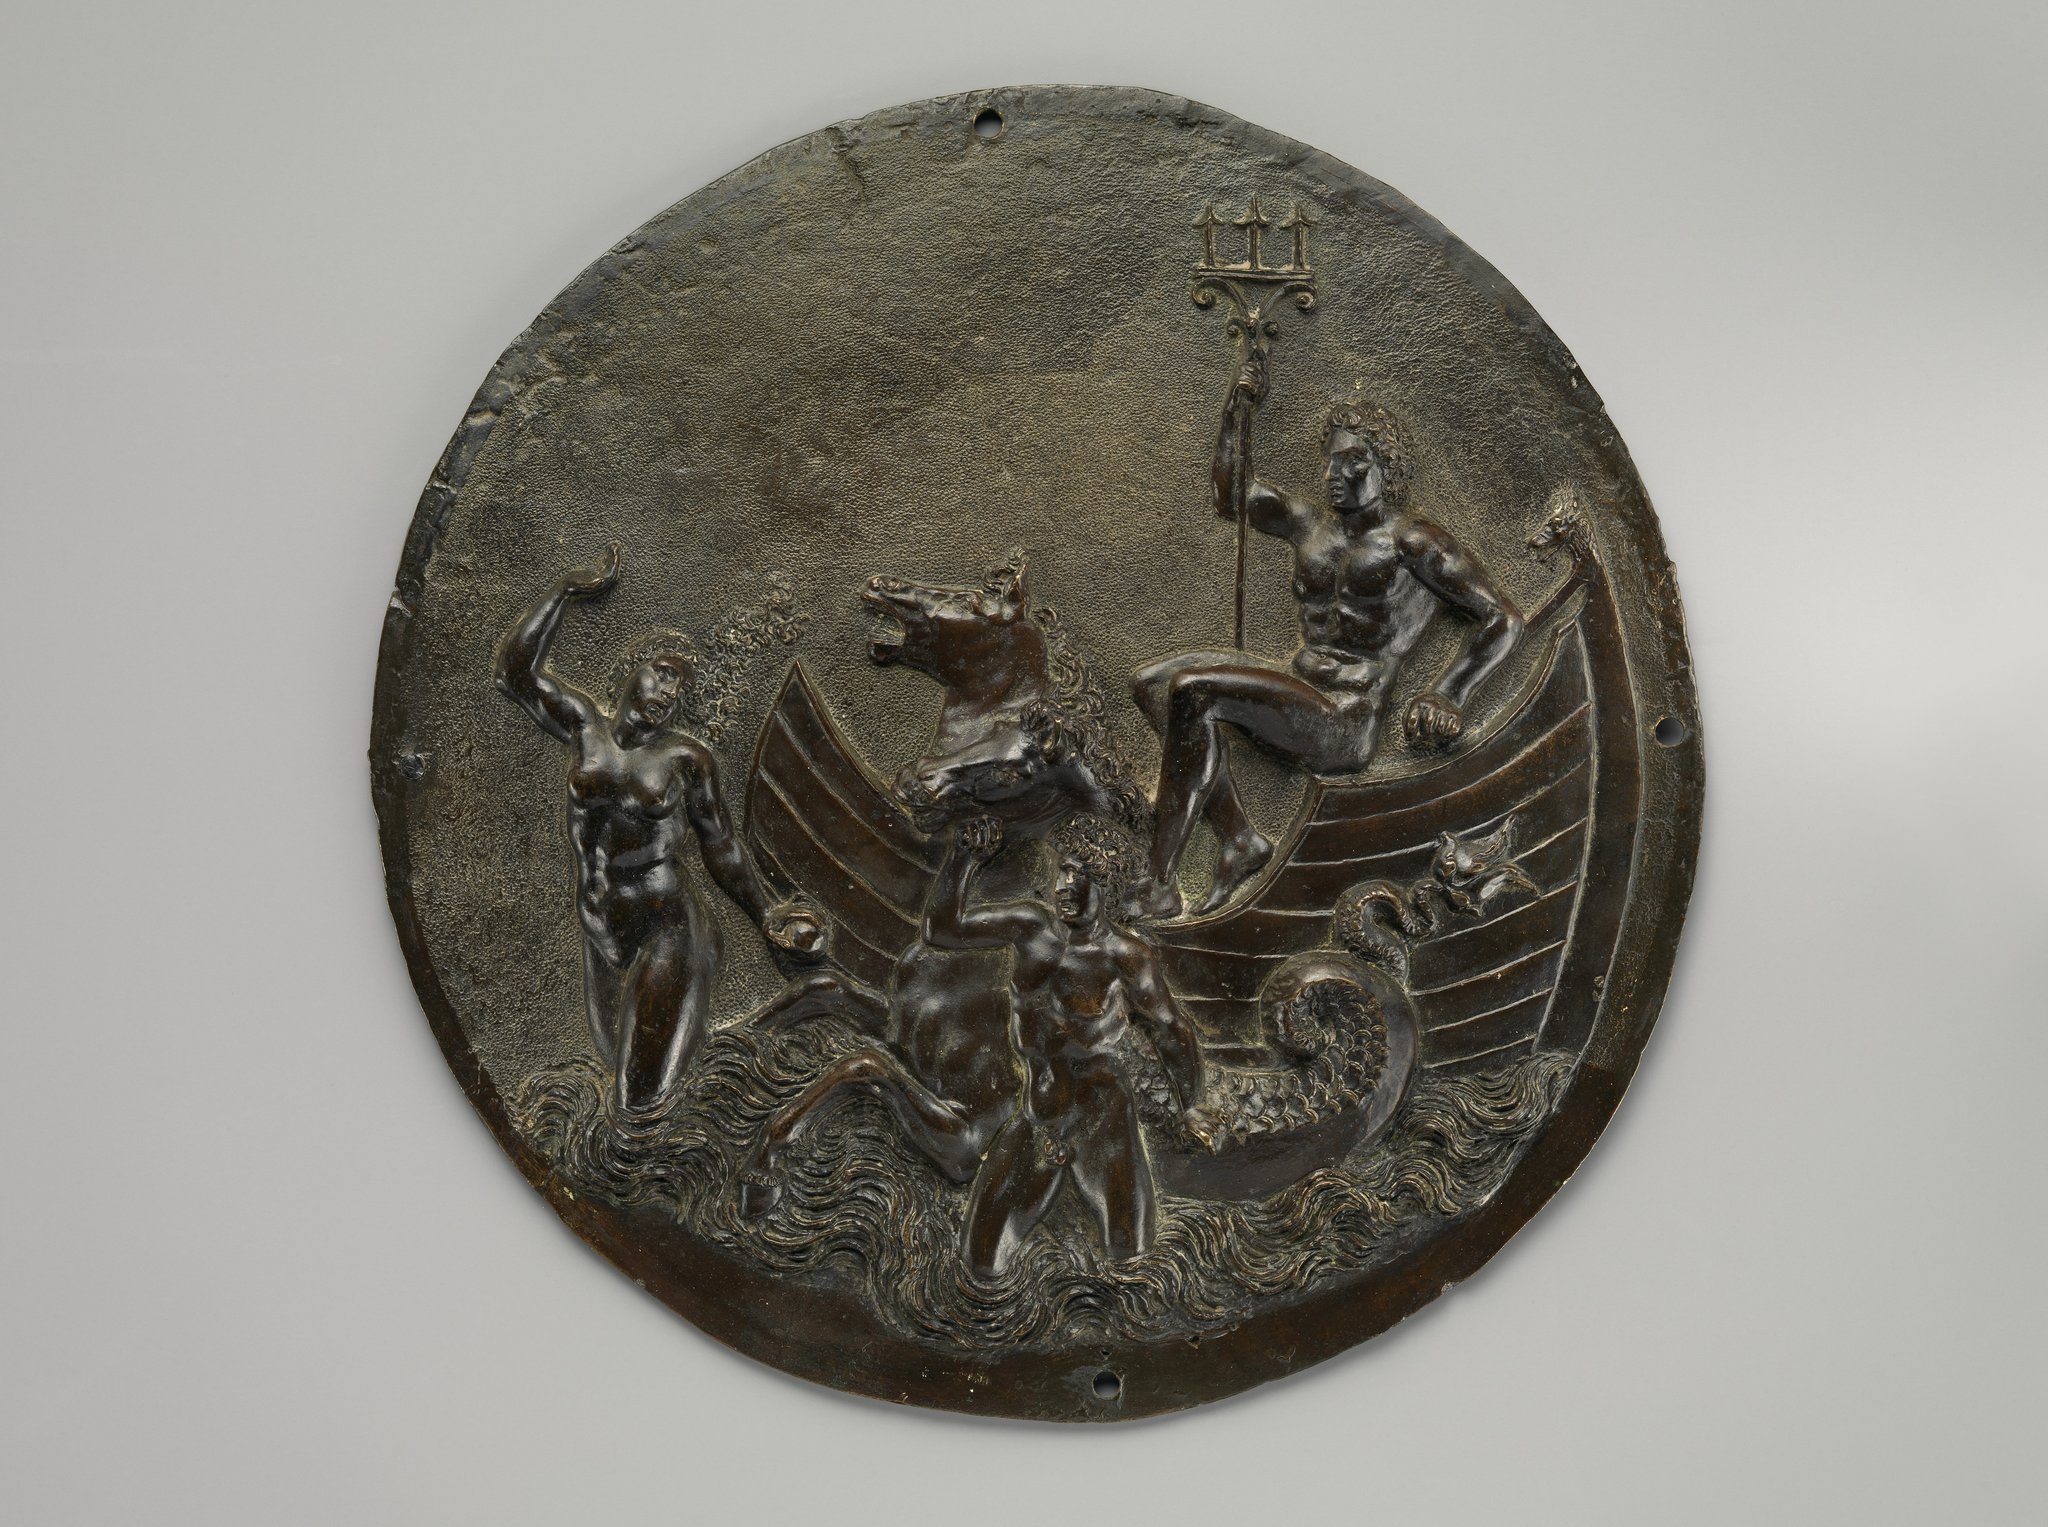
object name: tondo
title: Triumph of Neptune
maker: alvise of padua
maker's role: artist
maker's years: 1426-1526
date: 1515-1525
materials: bronze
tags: male nudes,female nudes,neptune,horses